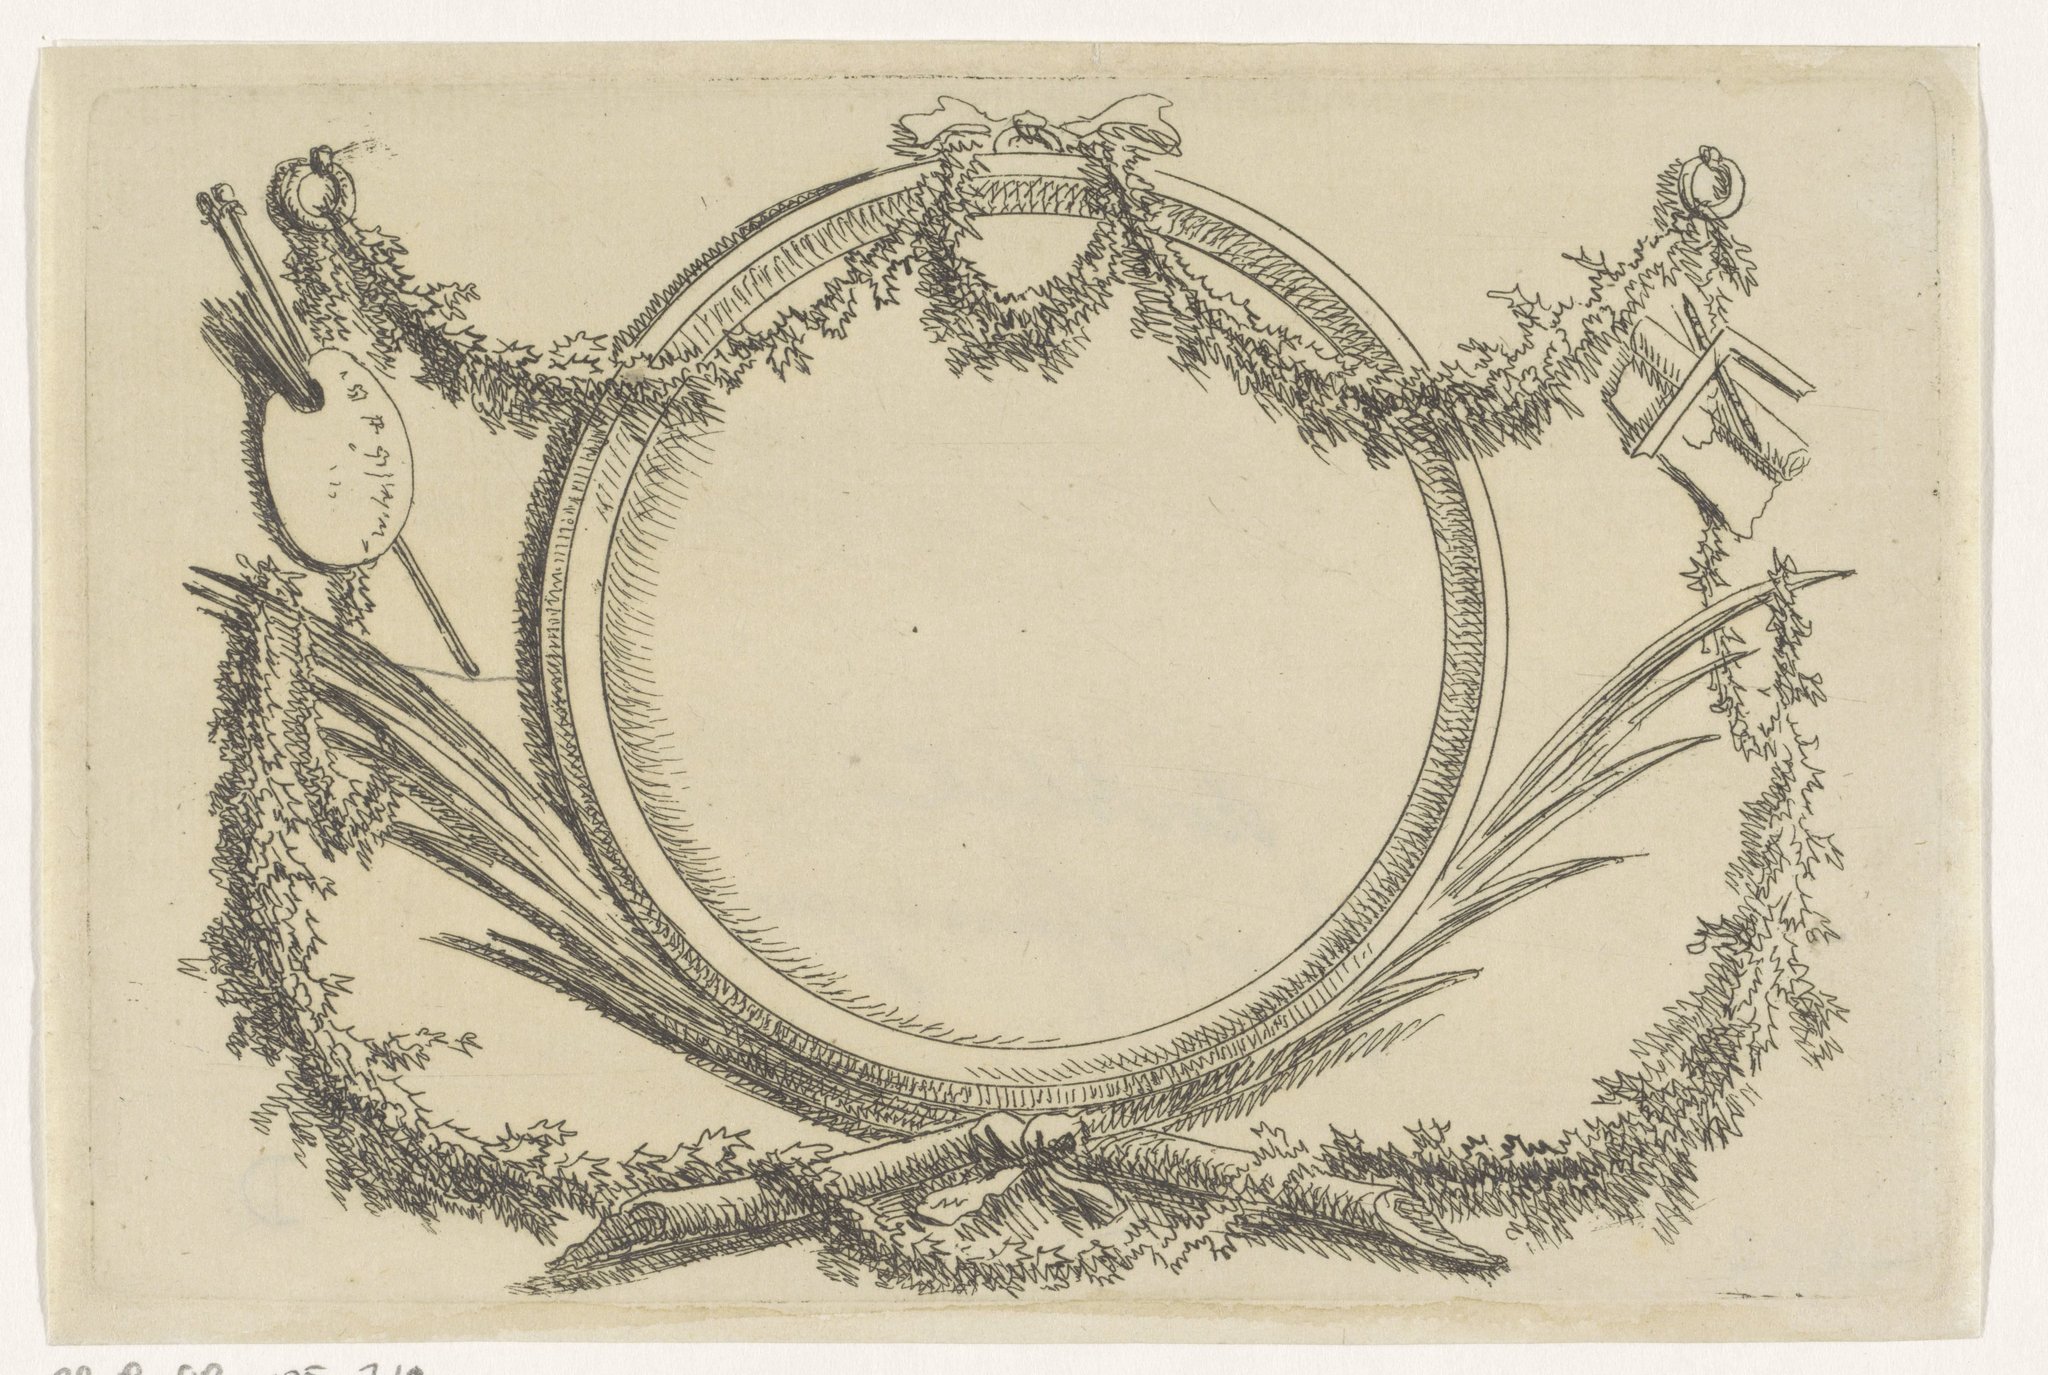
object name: ornament print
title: Ornamentele omlijsting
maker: gerard van nijmegen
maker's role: draughtsman, painter, print maker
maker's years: 1735-1808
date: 1745-1808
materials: paper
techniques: etching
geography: rotterdam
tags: palette, pencil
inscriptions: collector's mark: Lugt 2228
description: Ornamentele omlijsting met links een palet met penselen en schilderstok en rechts een pen en papier.